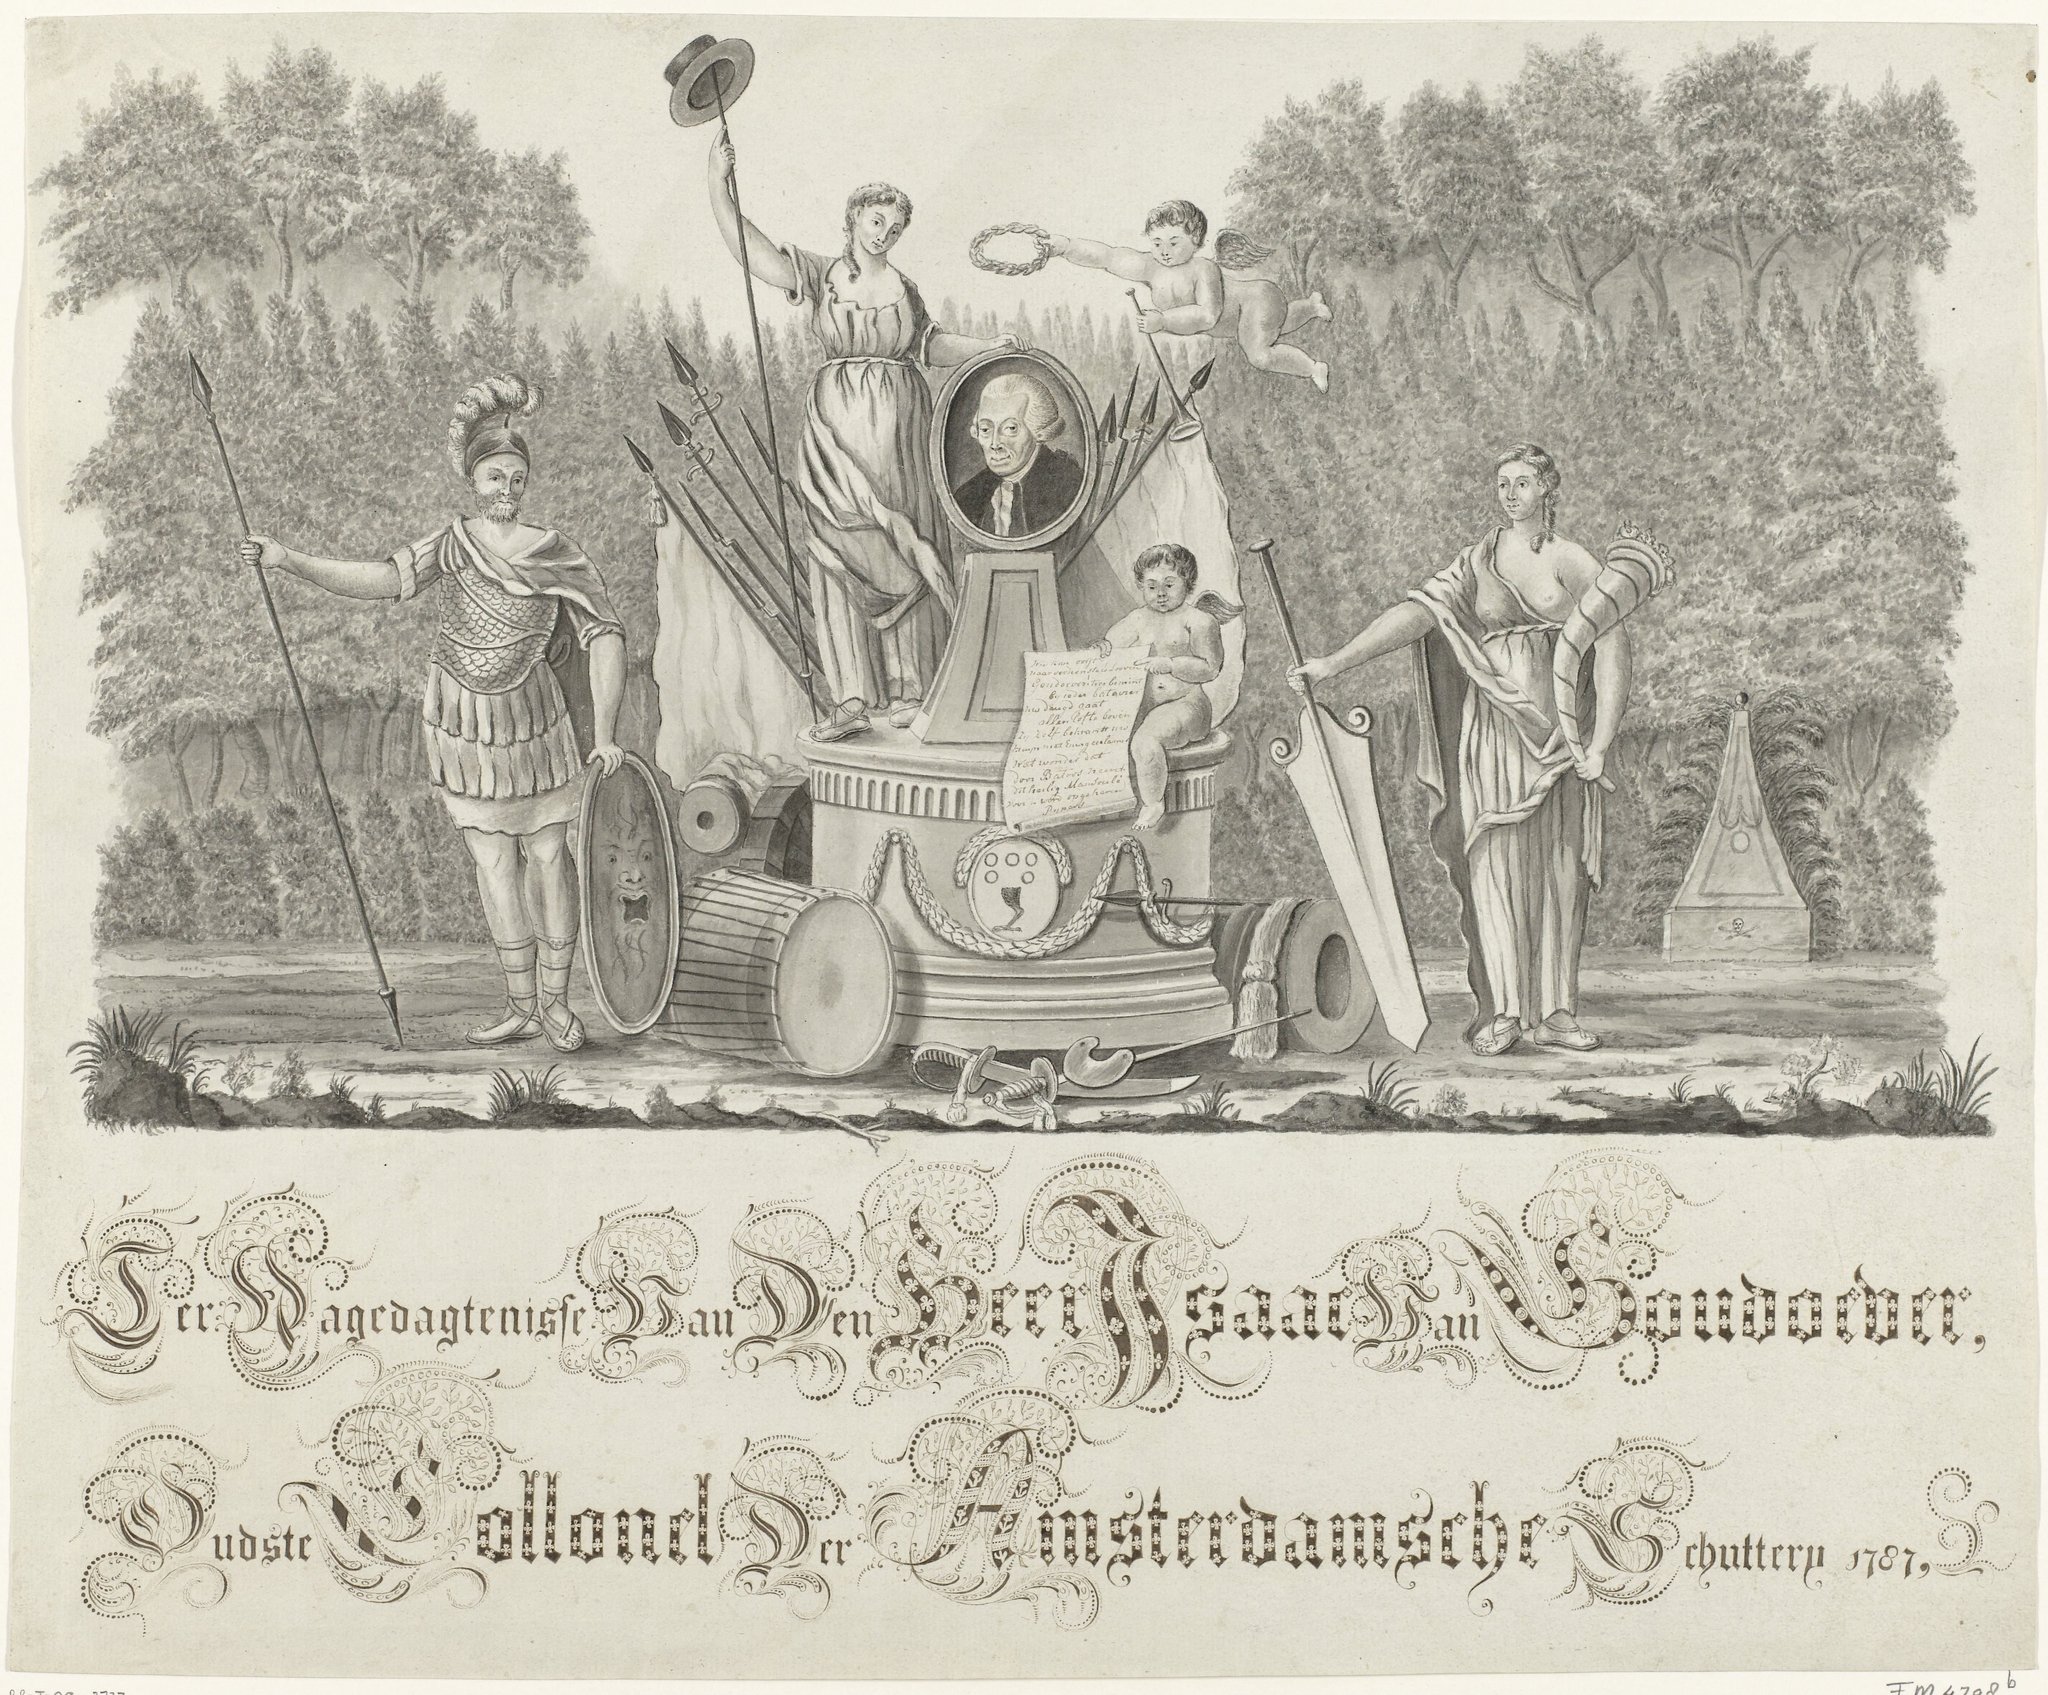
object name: calligraphy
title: Ter Nagedagtenisse van den Heer Isaac van Goudoever, Oudste Kollonel der Amsterdamsche Schuttery 1787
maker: Anonymous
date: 1793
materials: paper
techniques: calligraphy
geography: northern netherlands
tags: amsterdam, calligraphy, grave-building, monumental tomb, freedom, liberty; 'libertà' (ripa) (+ abstract concept represented by female figure), patriots (1780-1795)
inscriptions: collector's mark: Lugt 2228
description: Allegorisch grafmonument voor Isaak van Goudoever, overleden op 11 september 1793. Op het graf de Vrijheid met haar hand rustend op het portret van Goudoever op een afgebroken zuil. Links van de graftombe staat Minerva, rechts een allegorisch vrouwenfiguur met roer en hoorn van overvloed. Onder de voorstelling de gekalligrafeerde titel.